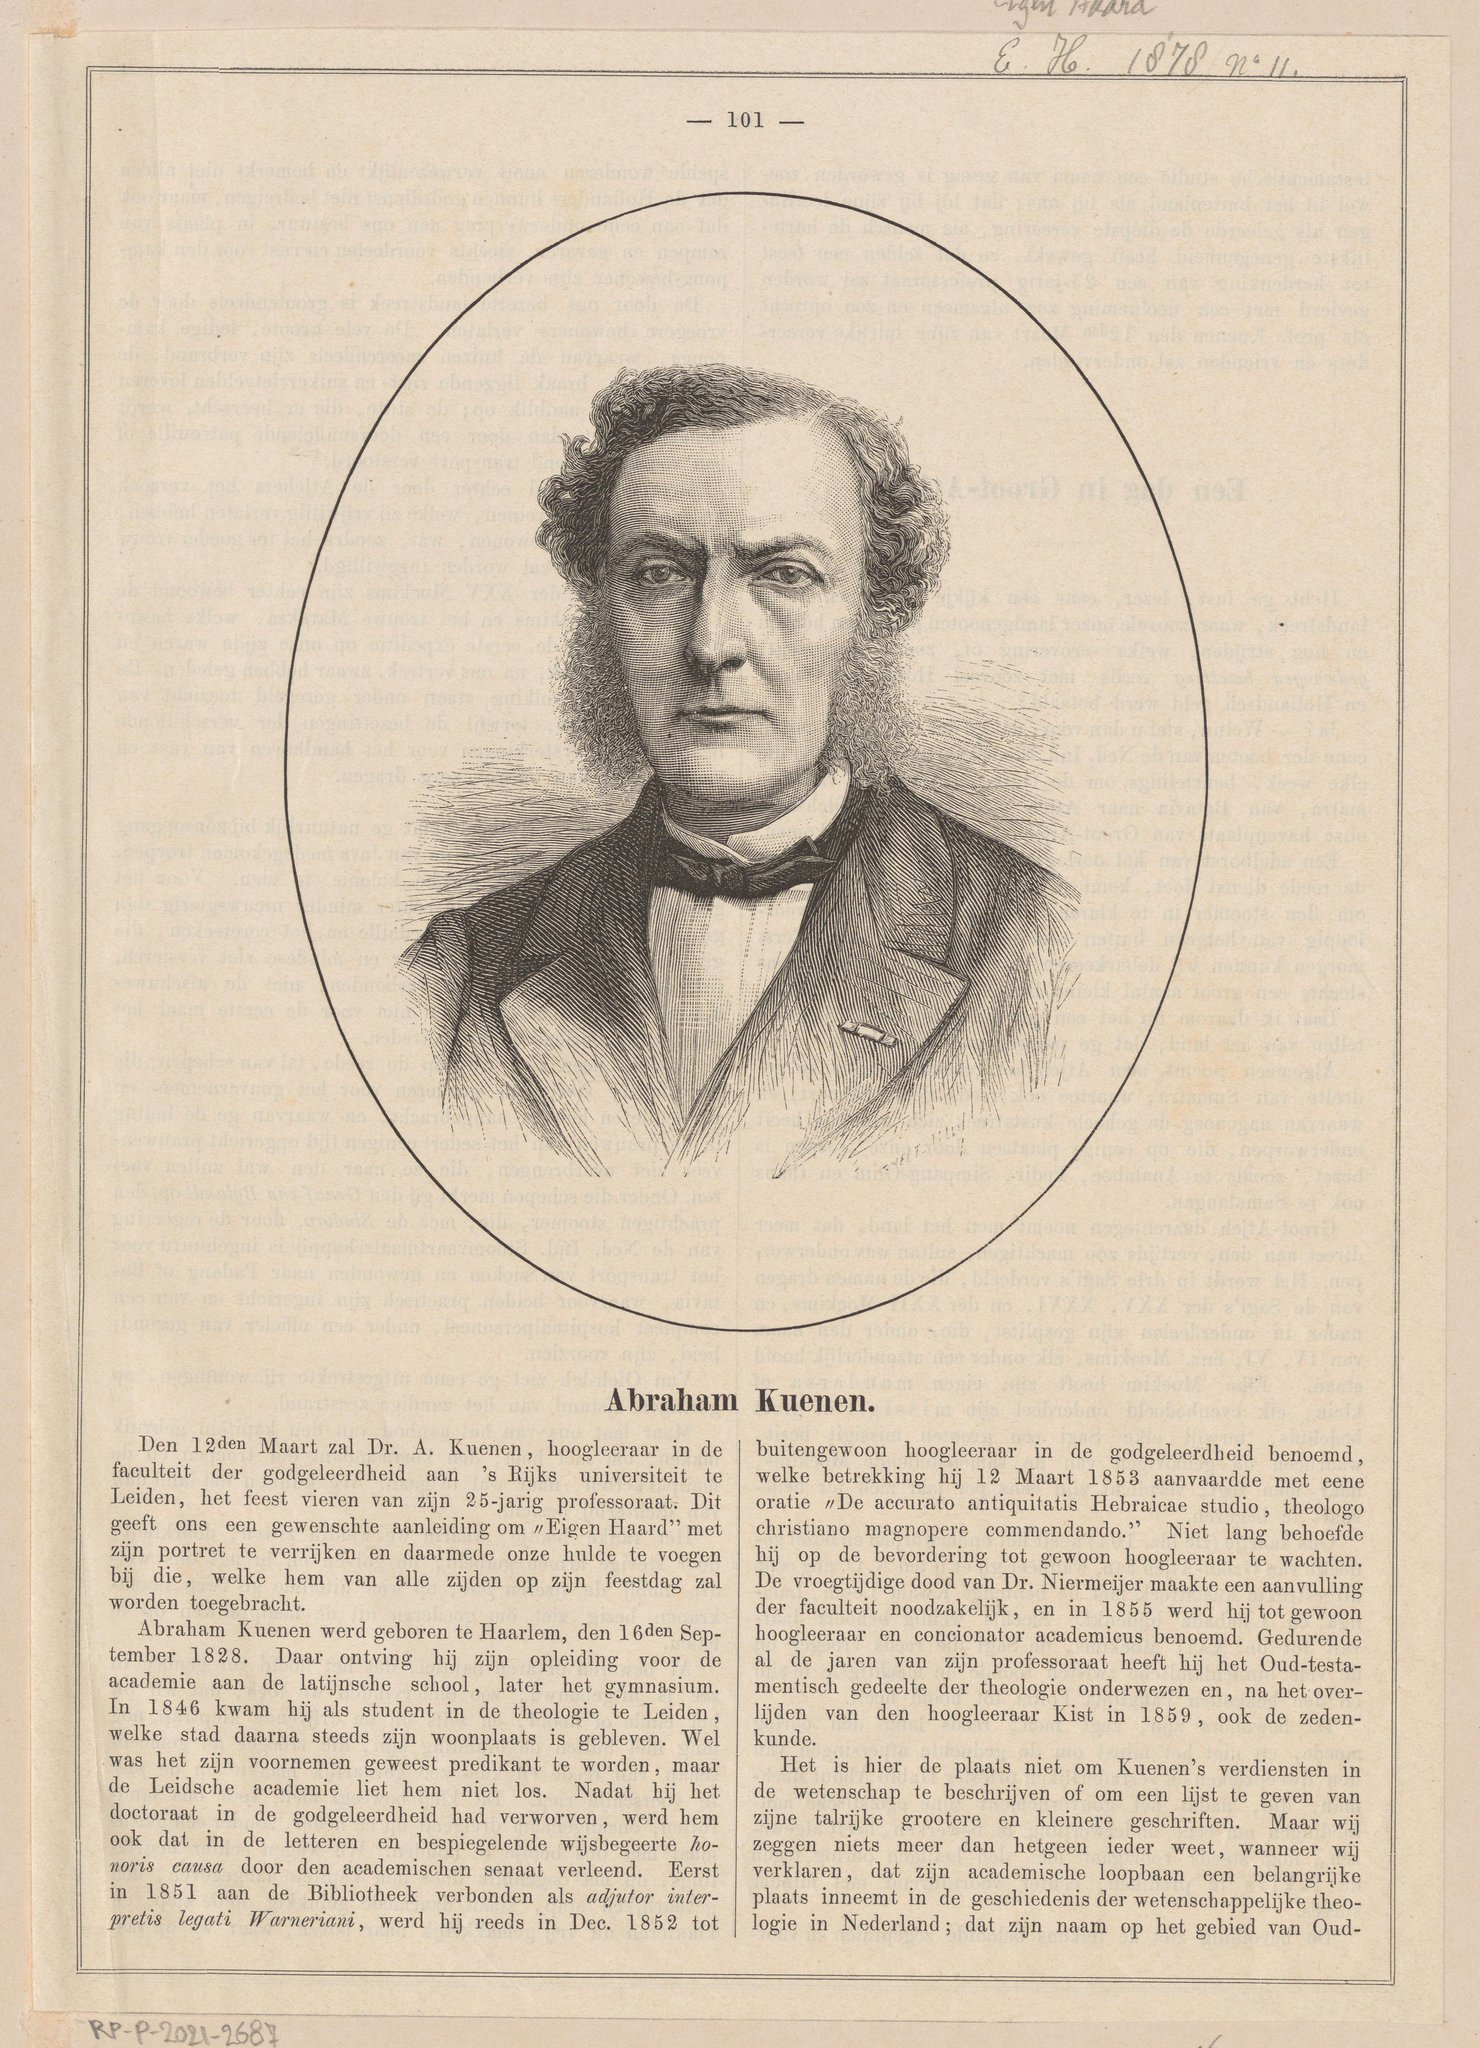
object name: print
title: Portret van Abraham Kuenen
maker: hermanus diedericus tjeenk willink (1843-1917)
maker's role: publisher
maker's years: 1843-1917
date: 1878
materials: paper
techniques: letterpress printing, engraving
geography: haarlem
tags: leiden, historical persons